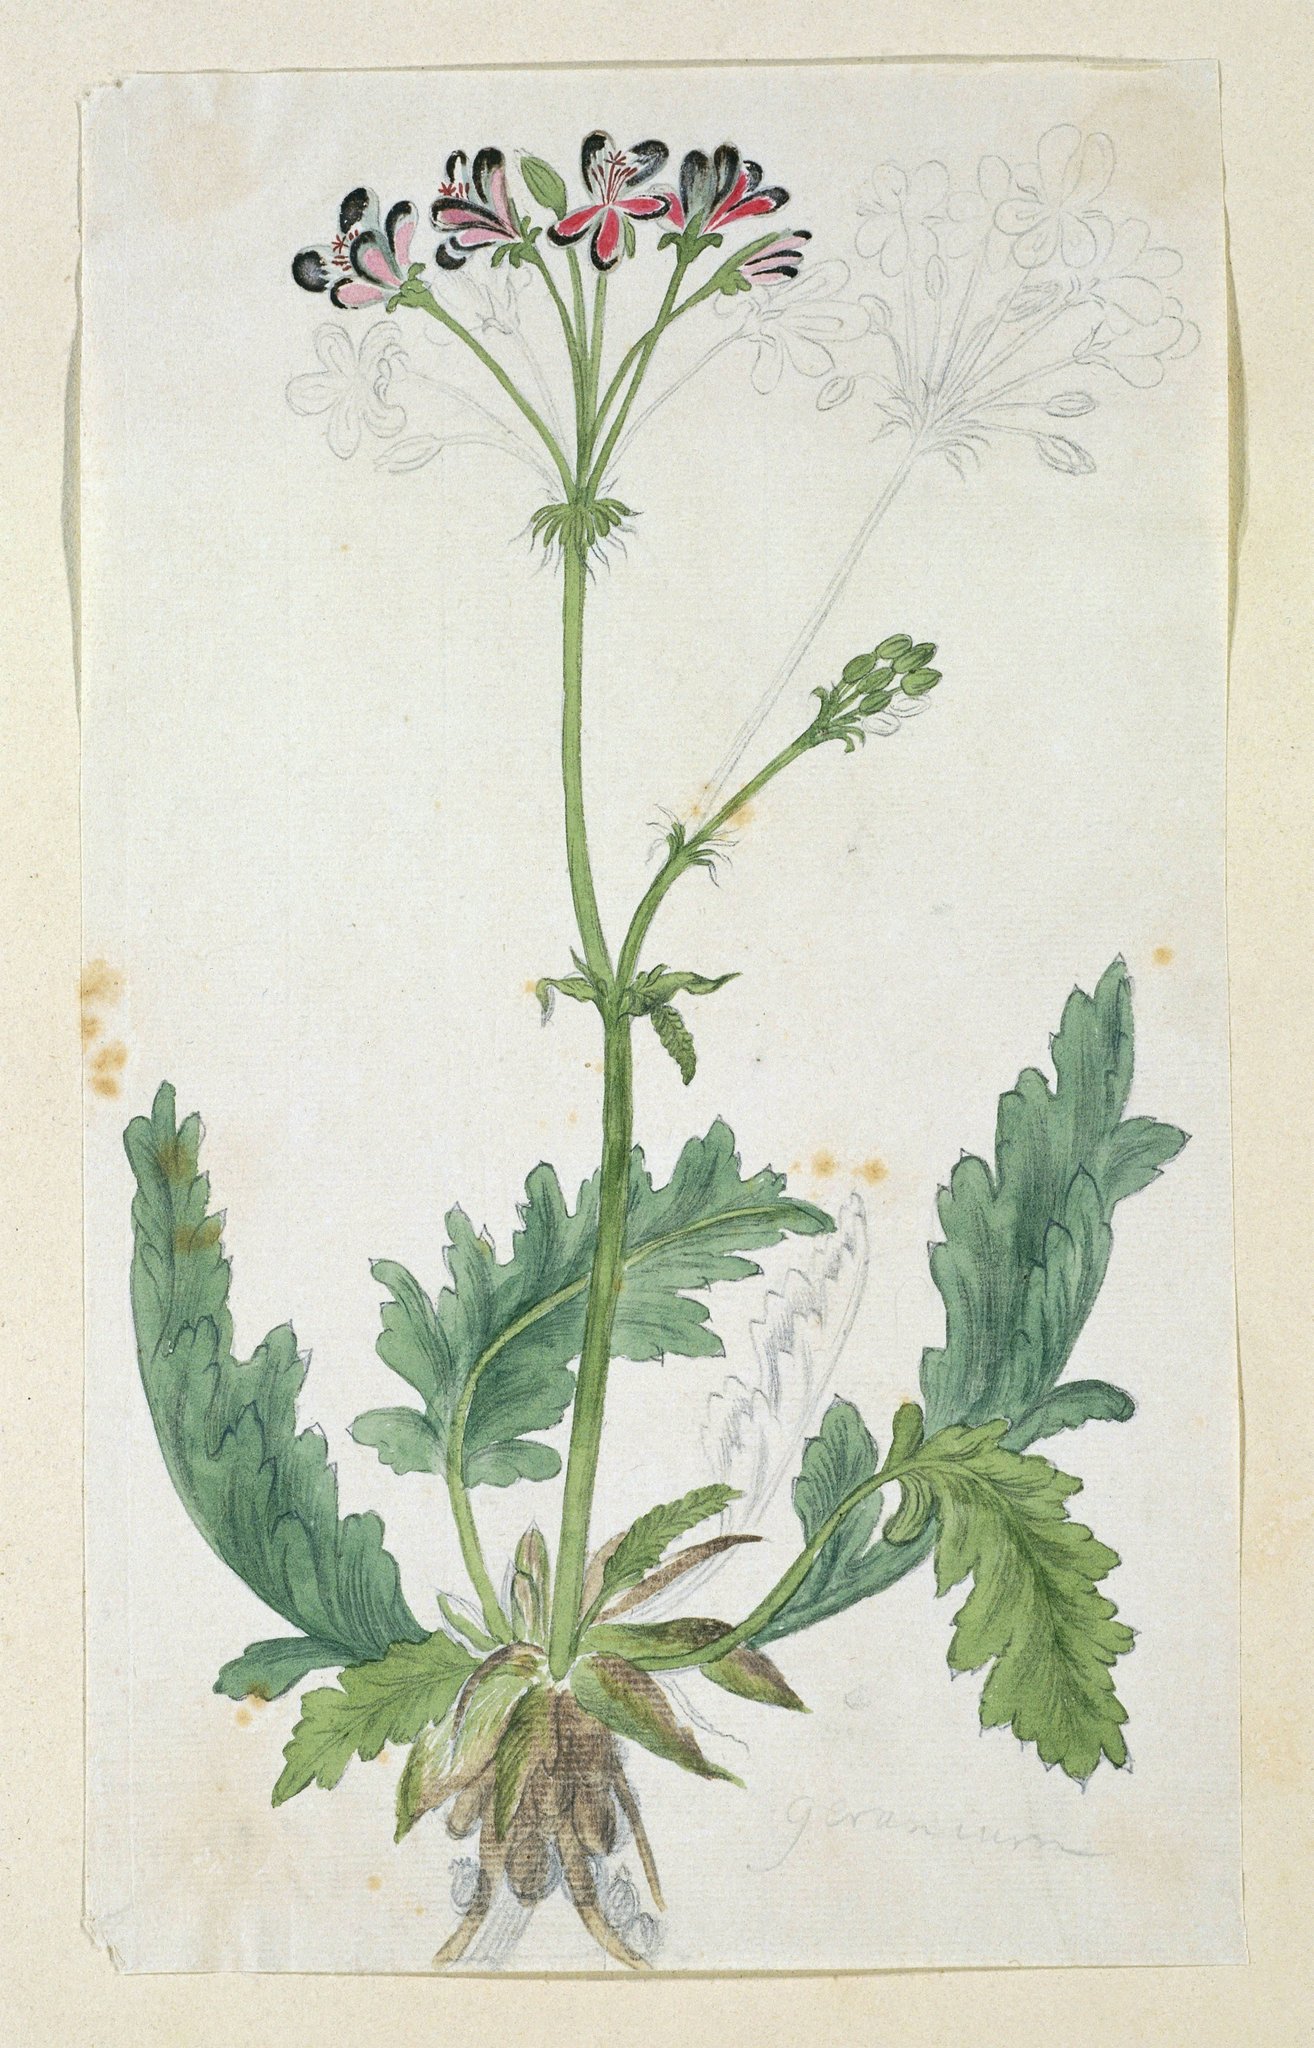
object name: drawing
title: Pelargonium pulchellum Sims (Nonesuch pelargonium)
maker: robert jacob gordon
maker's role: draughtsman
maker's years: 1743-1795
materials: chalk, paper, pencil, watercolor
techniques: brush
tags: plants; vegetation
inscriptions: annotation: ‘geranium’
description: De tekening is gemaakt voor of tijdens een van Gordon's vier expedities door de Kaapprovincie, van oktober 1777 tot maart 1786. Sommige (soort)namen kunnen zijn gewijzigd, gezien reorganisatie in plantentaxonomie gedurende de afgelopen jaren.